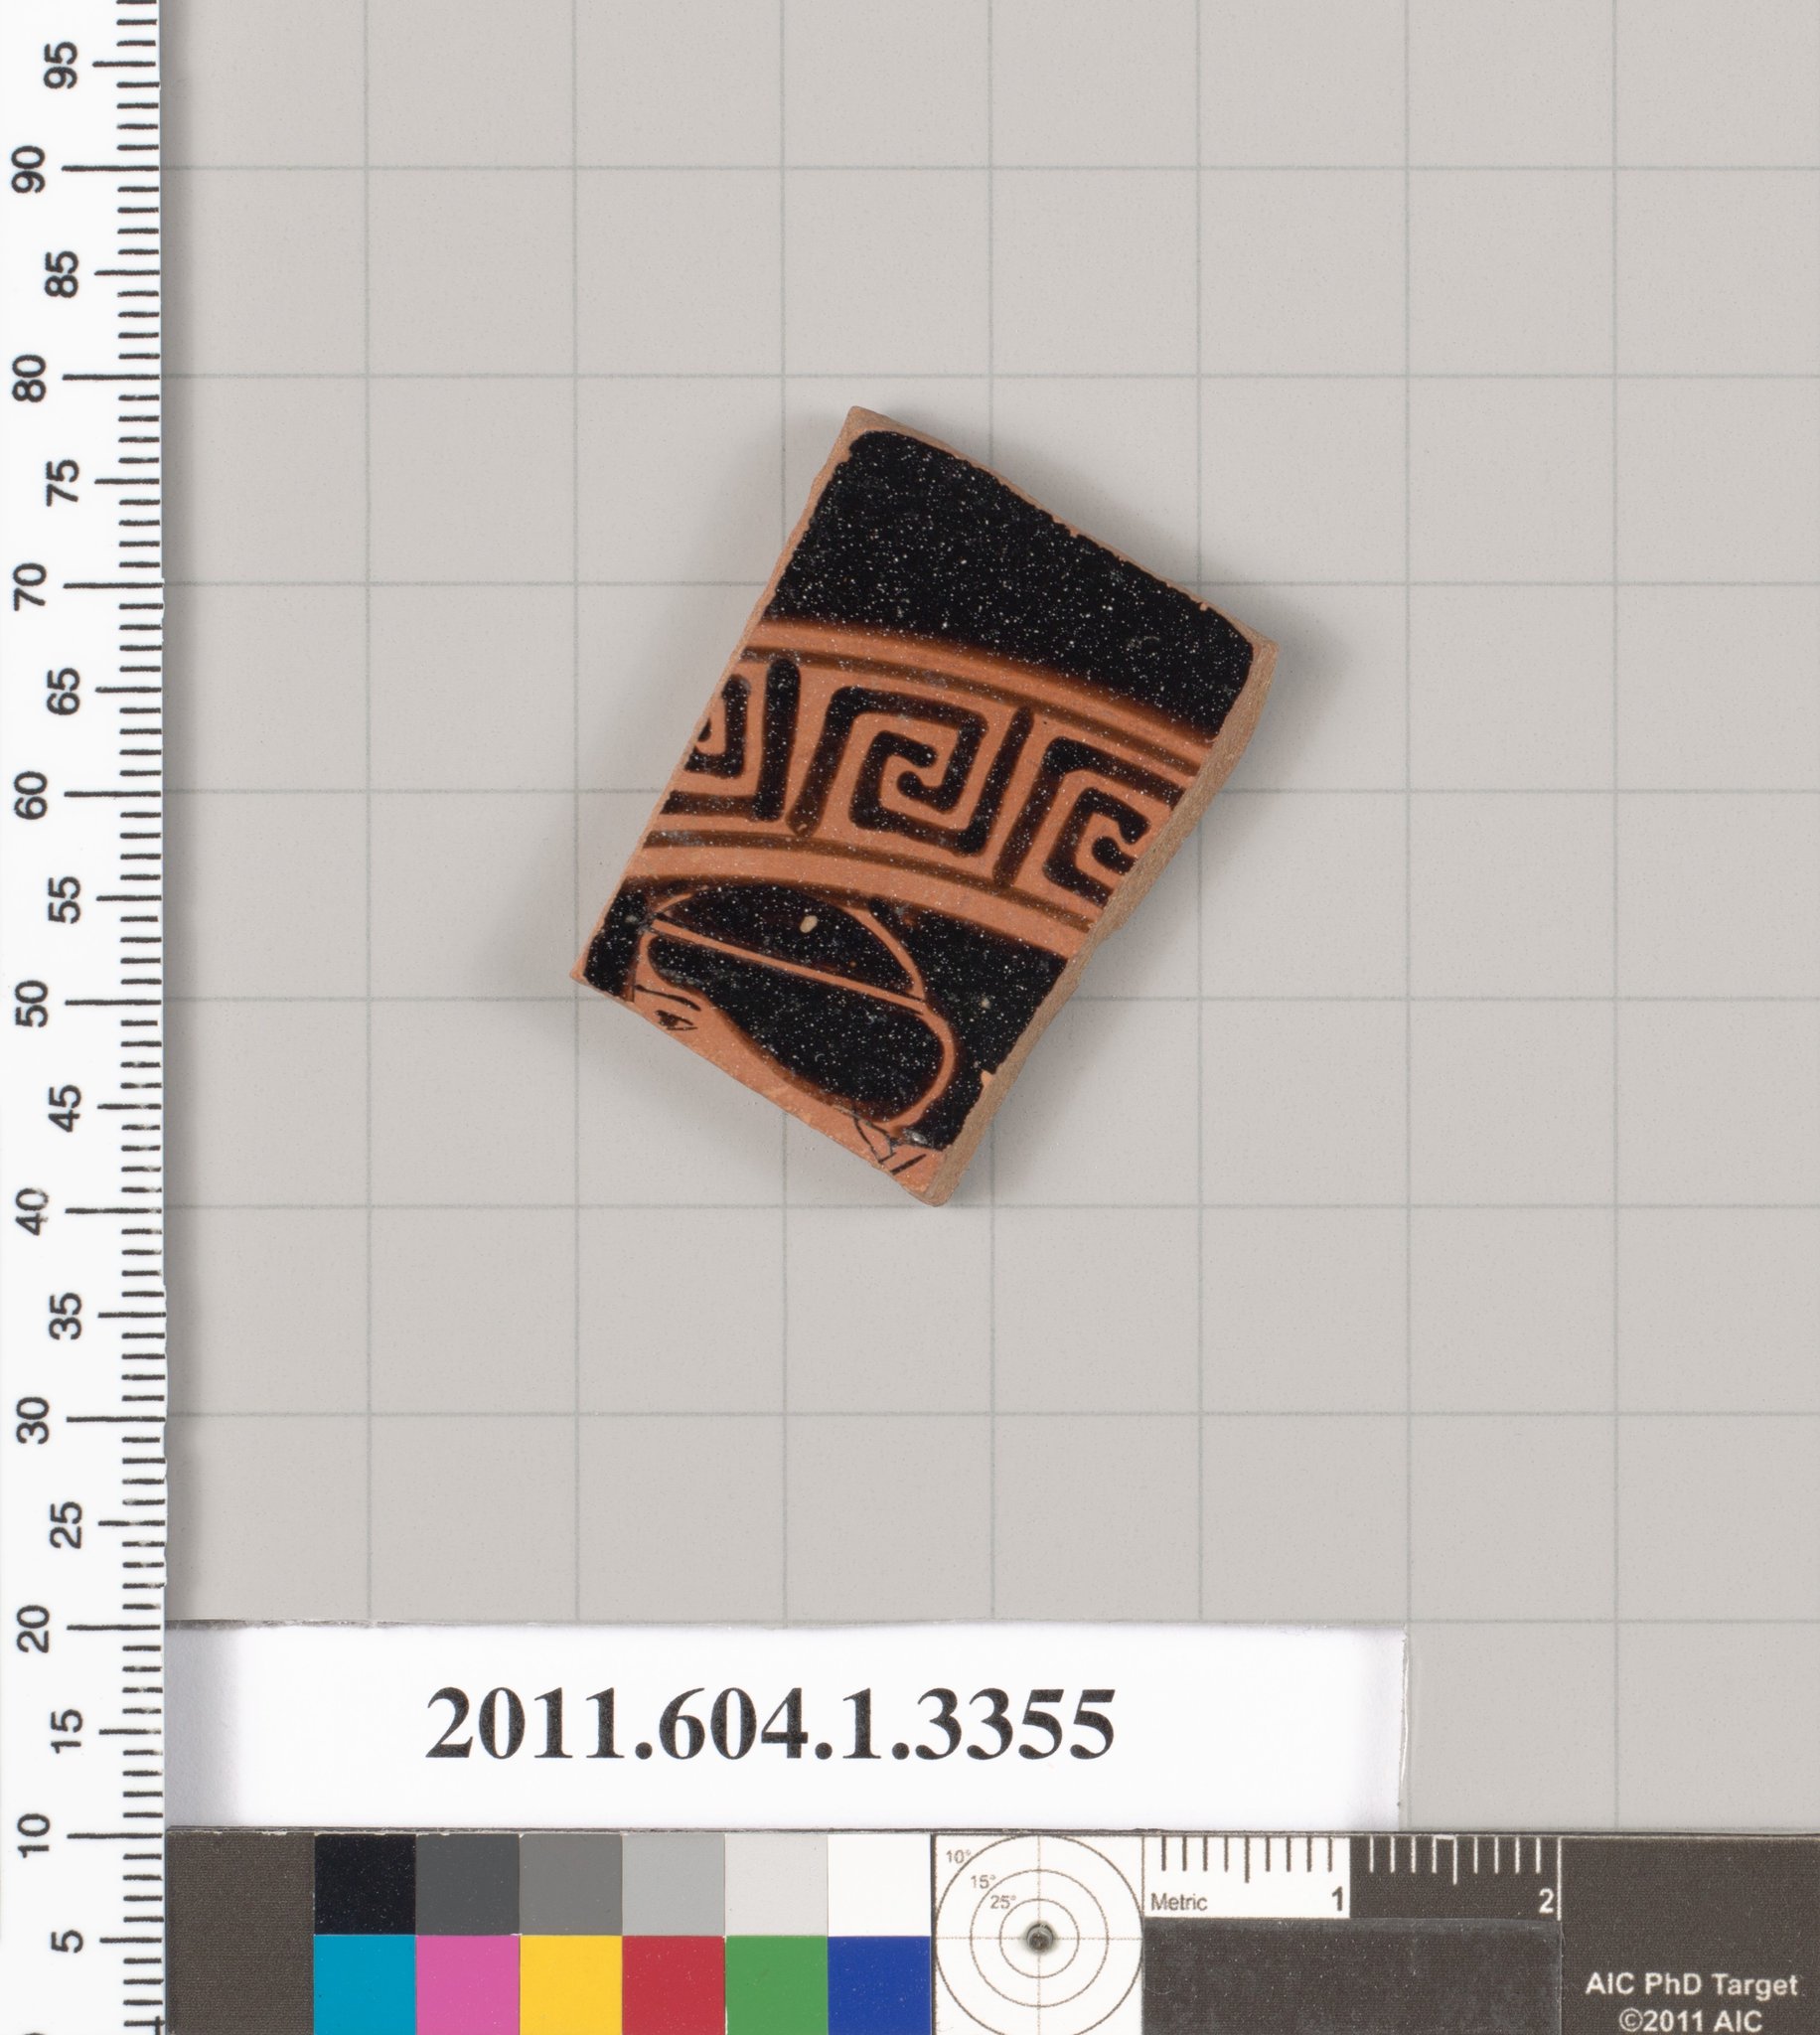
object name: kylix fragment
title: Terracotta fragment of a kylix (drinking cup)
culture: greek, attic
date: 475-451 BCE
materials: terracotta